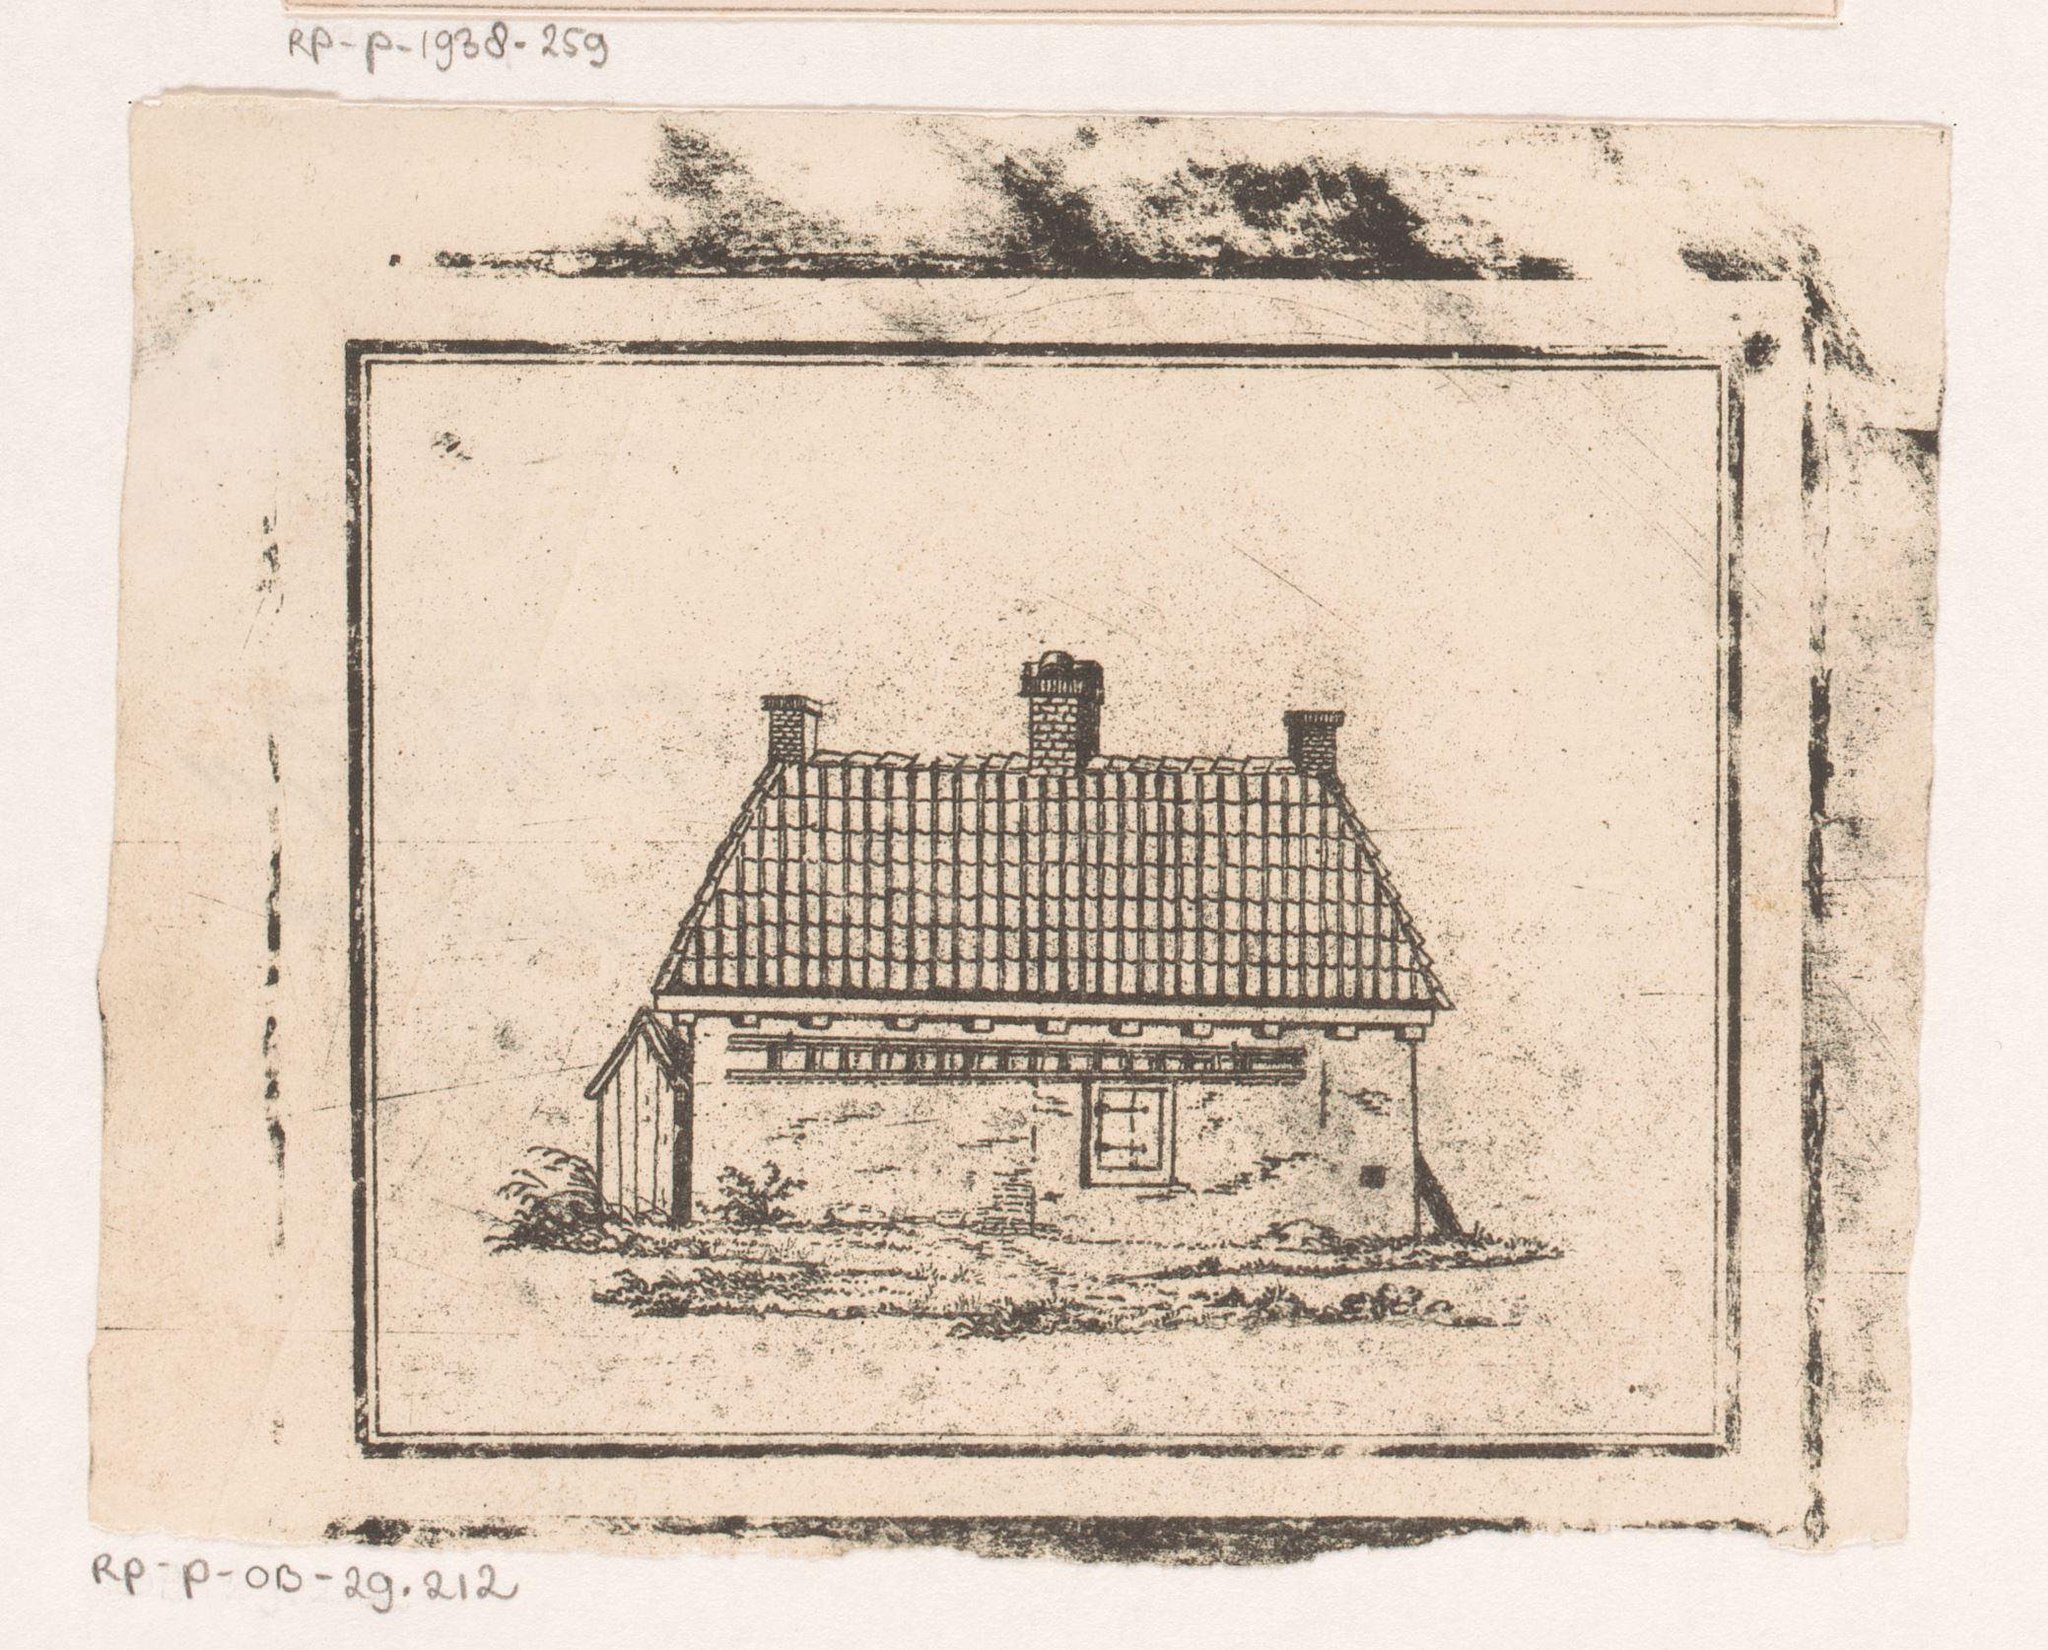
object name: print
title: Zijaanzicht van een huis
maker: jean zacherie mazel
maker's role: draughtsman, print maker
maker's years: 1792-1884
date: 1819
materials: paper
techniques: lithograph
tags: lavatory, water-closet, housing, ladder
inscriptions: inscription: ‘geschenk van / den H. Mazell / Sept 1885’, collector's mark: Lugt 2228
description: Aan de muur hangt een ladder. Links een wc-huis.